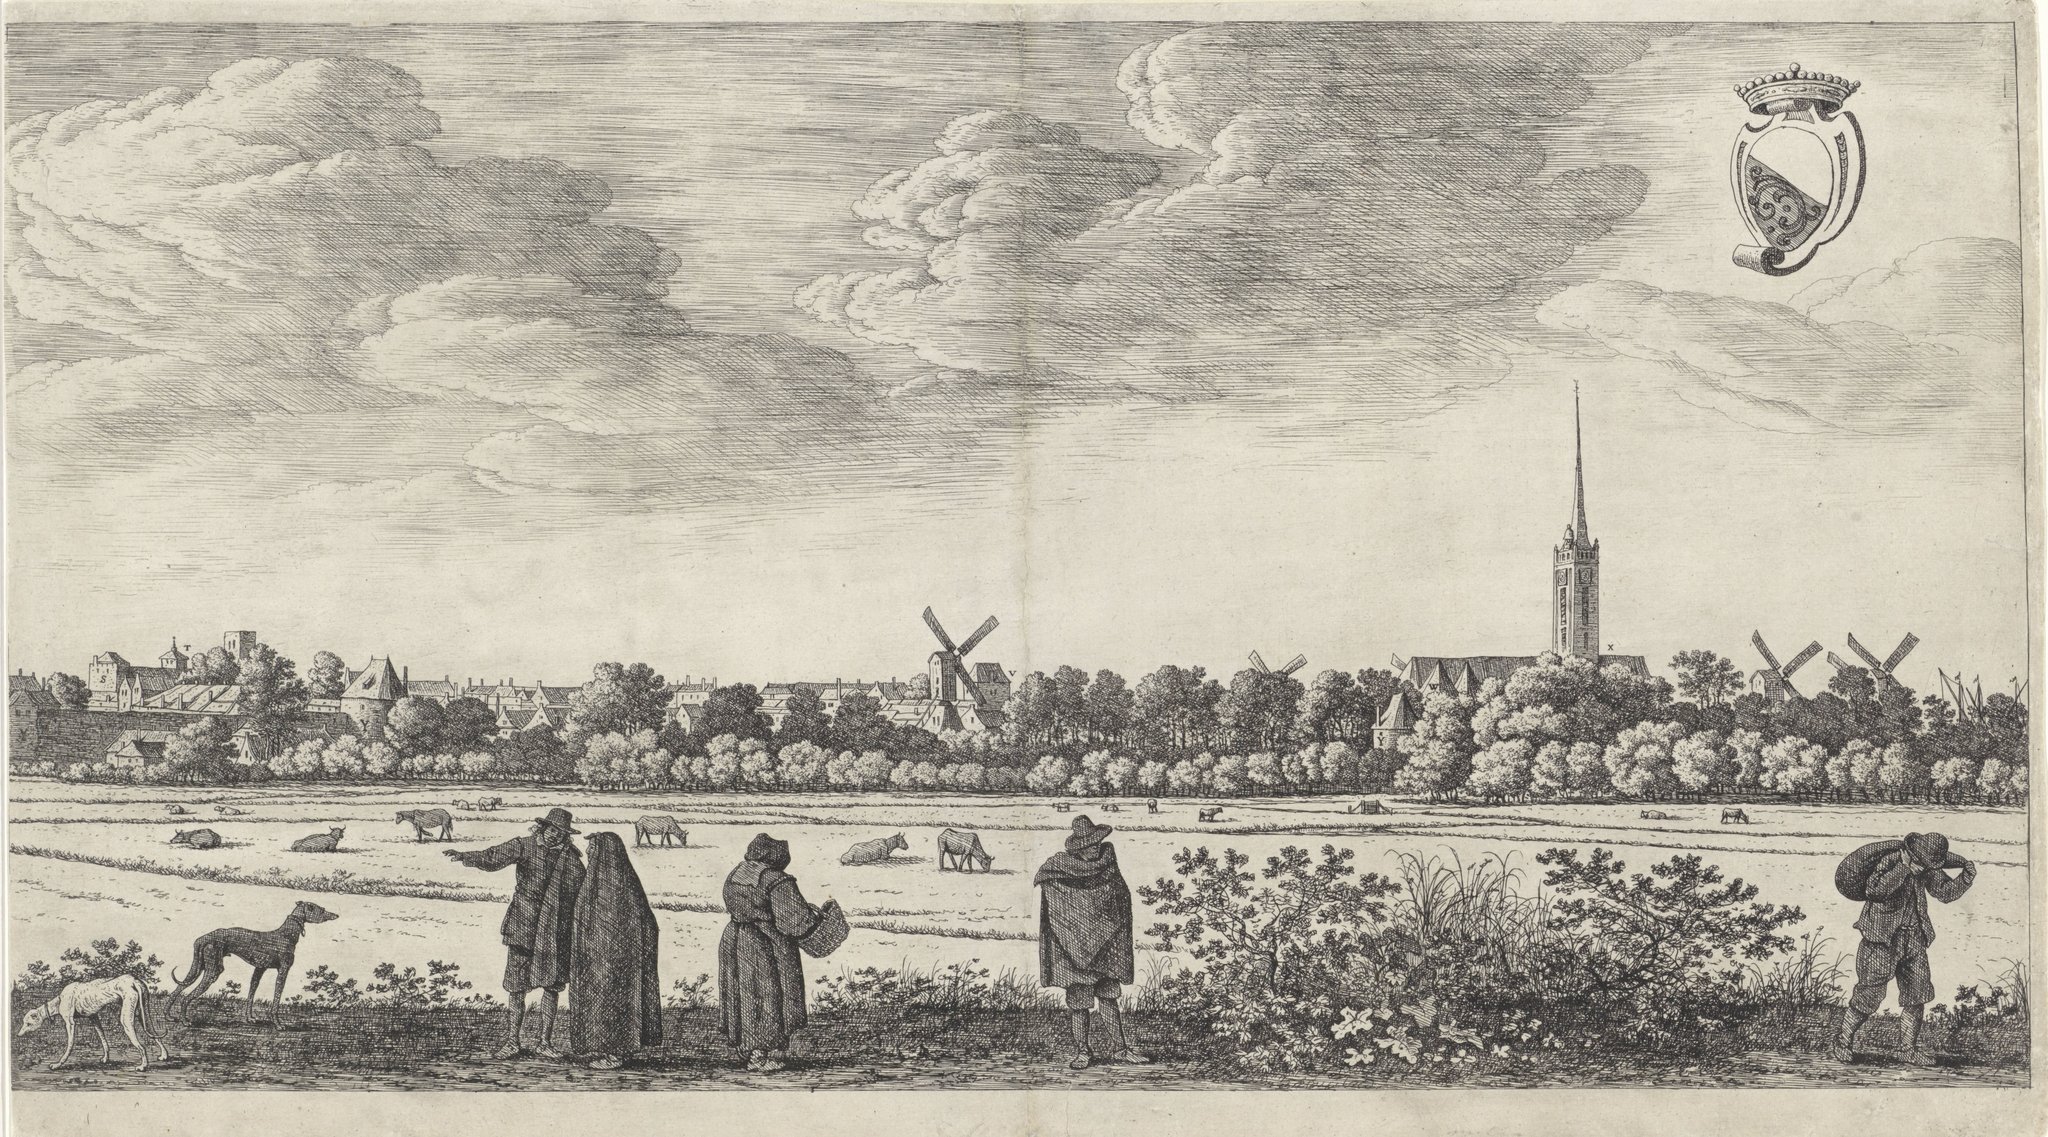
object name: print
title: Gezicht op Utrecht, (plaat III)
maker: herman saftleven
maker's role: draughtsman, painter, print maker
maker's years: 1609-1685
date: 1648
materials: paper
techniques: etching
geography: utrecht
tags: cow, church (exterior), utrecht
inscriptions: date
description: Rechterplaat van 'Gezicht op Utrecht' met een gedeelte van Utrecht. Op de voorgrond enkele figuren en weilanden met koeien. Op de achtergrond, achter een bomenrij de stad Utrecht met molens en een kerk. Geheel rechts, half verscholen achter het geboomte, enkele scheepsmasten.